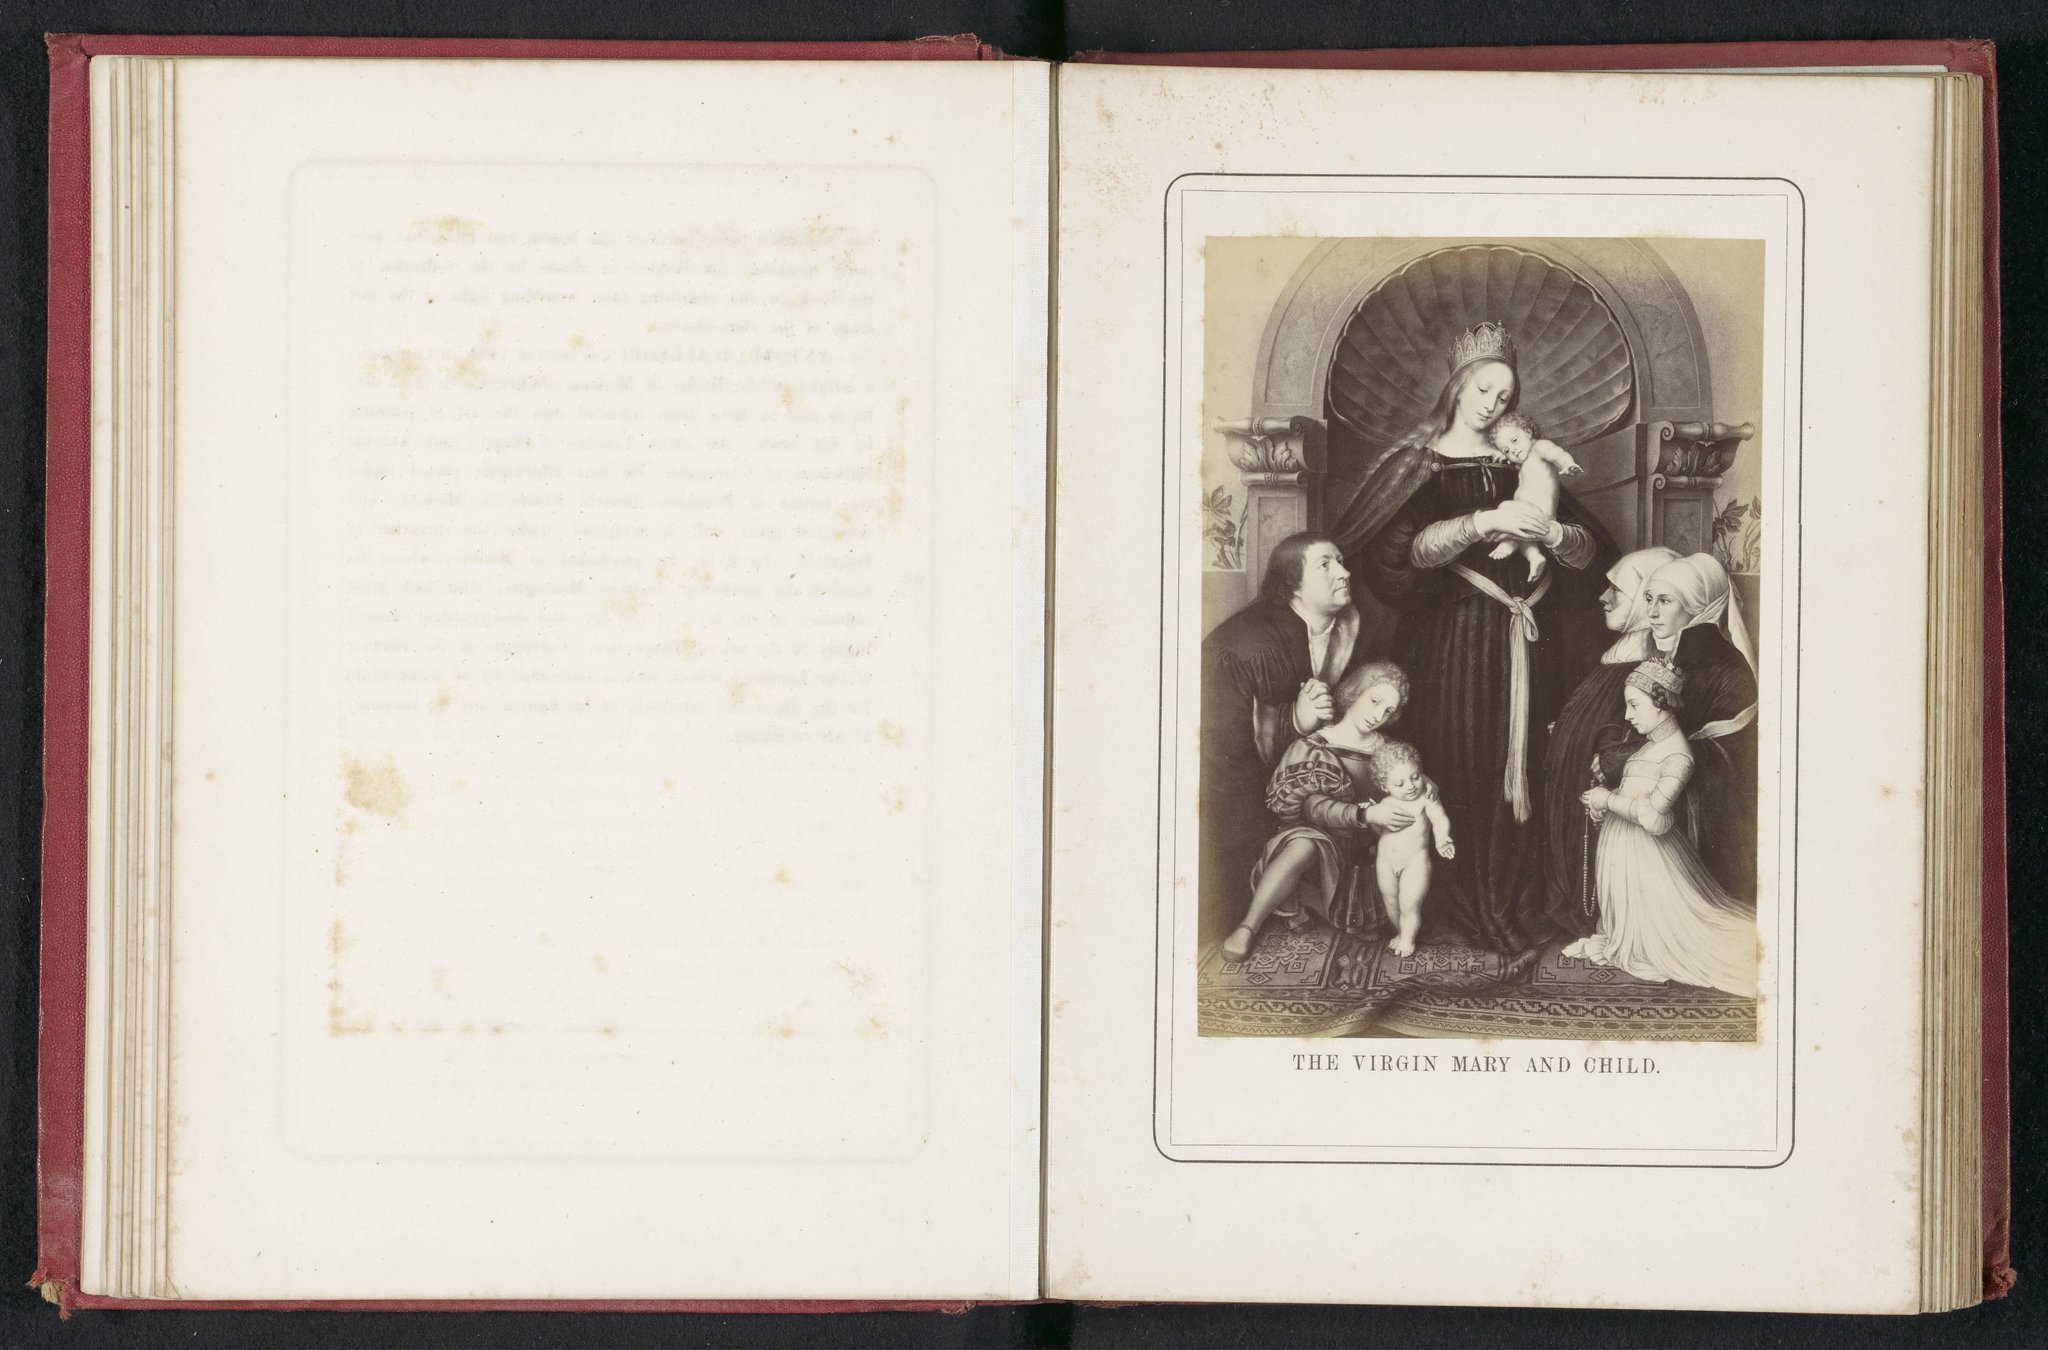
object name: page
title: Fotoreproductie van een schilderij van Maria met Kind door Hans Holbein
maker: hanns hanfstaengl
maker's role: print maker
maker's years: 1820-1885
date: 1854-1864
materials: photographic support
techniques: albumen print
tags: madonna: i.e. mary with the christ-child, picture, painting